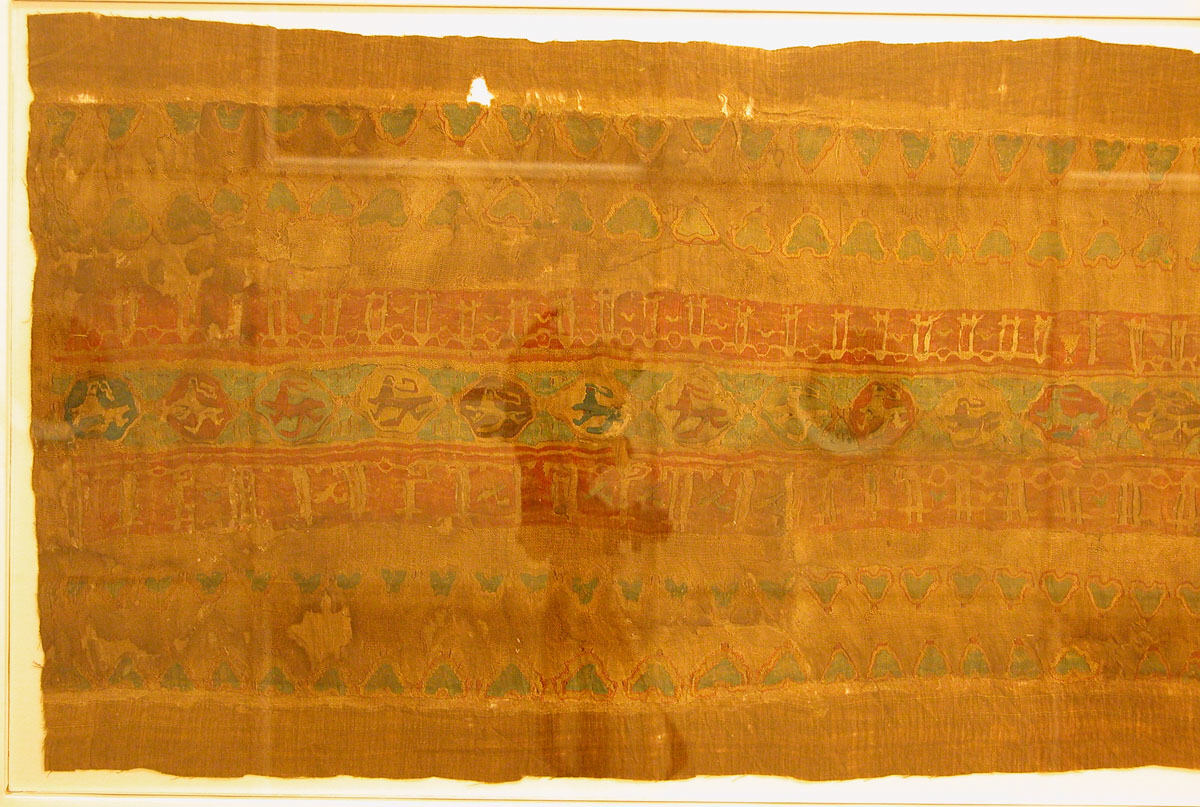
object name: textile fragment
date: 1034-1066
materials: linen, silk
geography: egypt